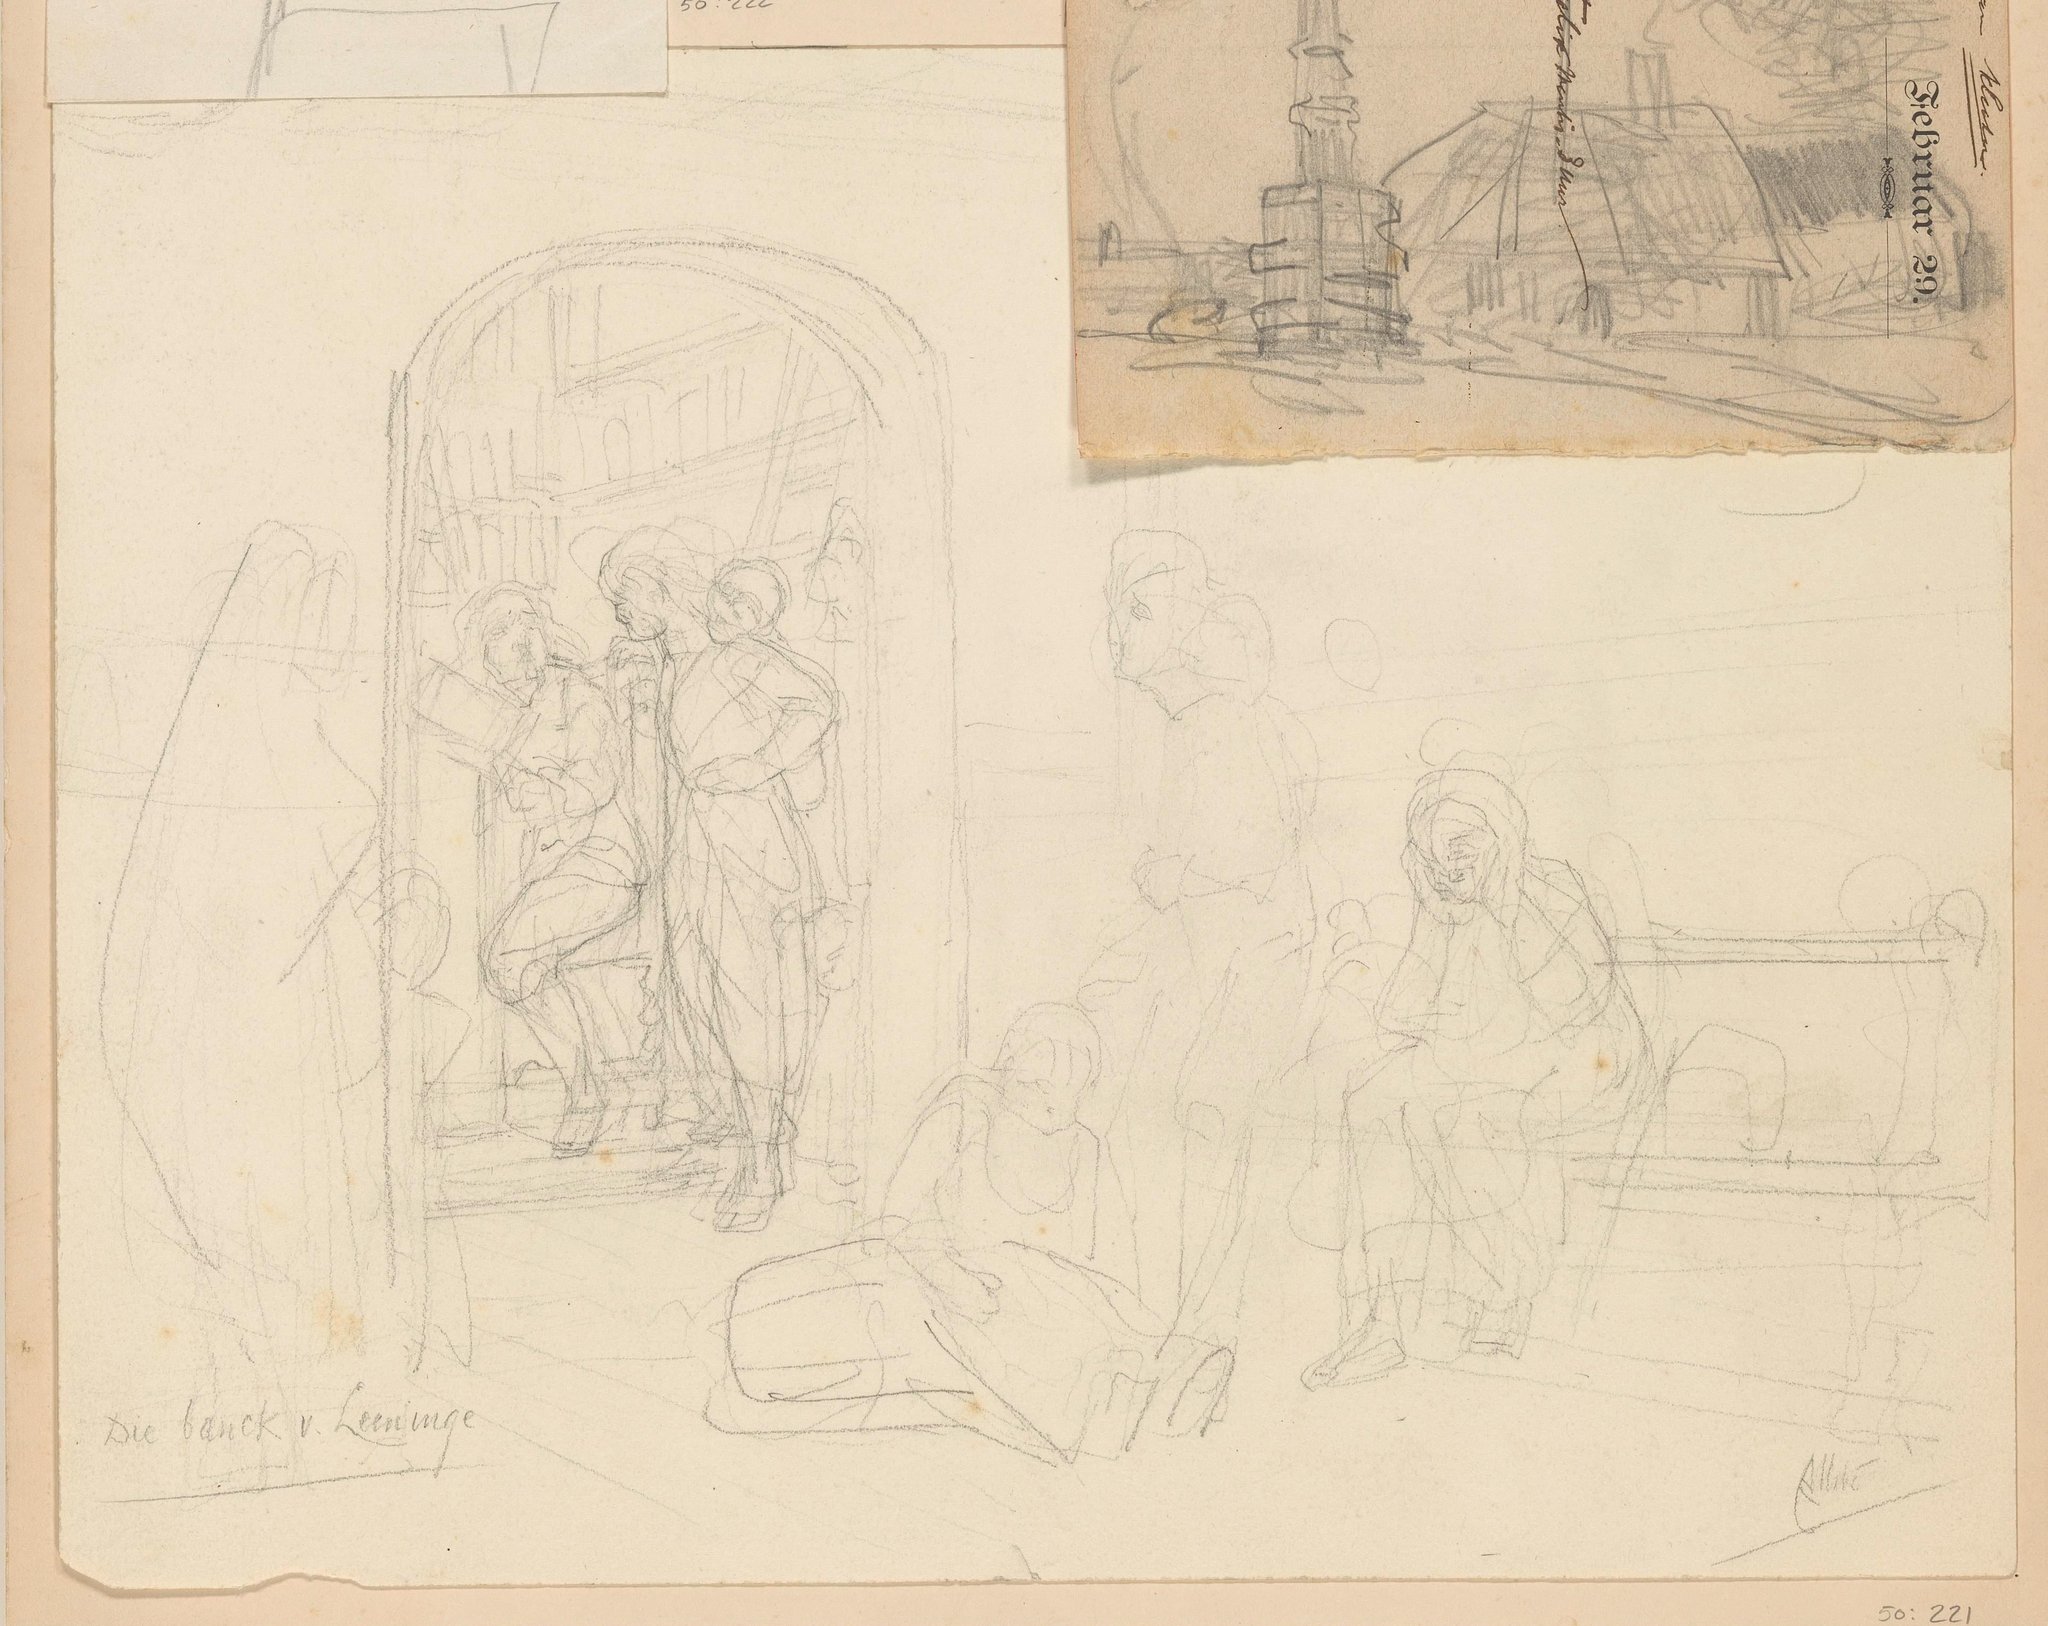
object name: drawing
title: Vondel in de bank van leeninge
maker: august allebé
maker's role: draughtsman, print maker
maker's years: 1838-1927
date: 1848-1927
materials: paper, pencil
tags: cologne, amsterdam, joost van den vondel, historical persons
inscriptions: inscription: ‘Die banck van Leeninge’